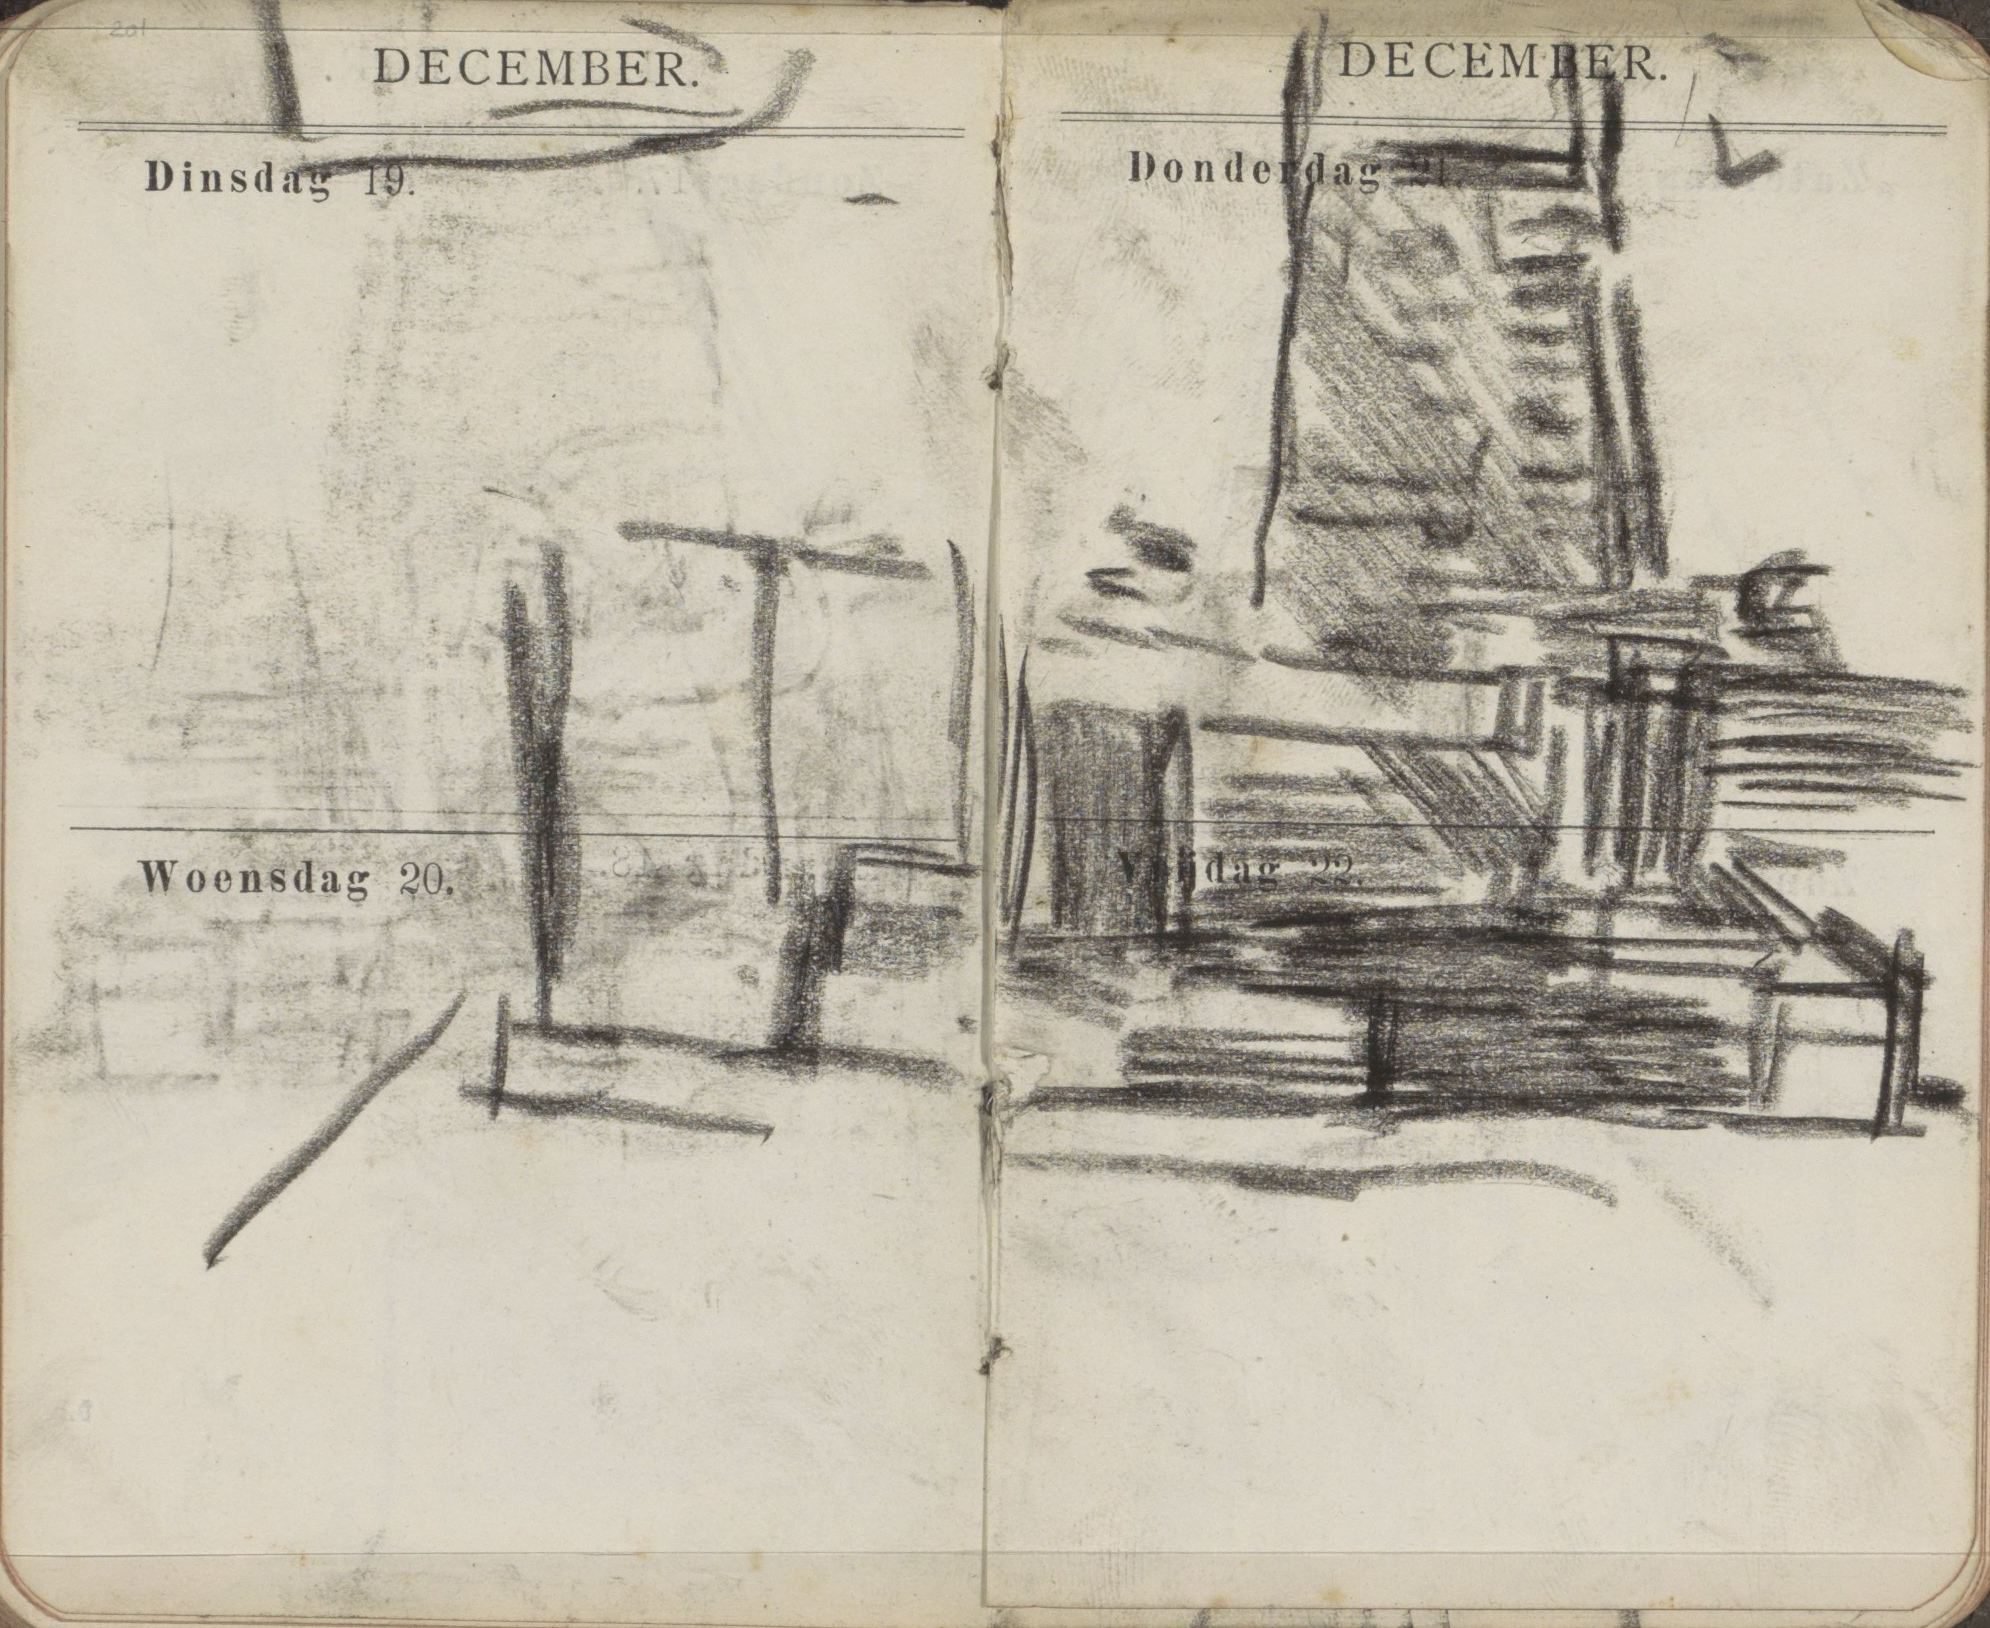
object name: sketchbook leaf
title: Gezicht in Amsterdam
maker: george hendrik breitner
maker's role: draughtsman, painter, print maker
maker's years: 1857-1923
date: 1893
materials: chalk, paper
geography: amsterdam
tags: city-view, and landscape with man-made constructions, civic architecture; edifices; dwellings, amsterdam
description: Pagina 201 en pagina 202 uit een als schetsboek gebruikte agenda met 108 bladen.